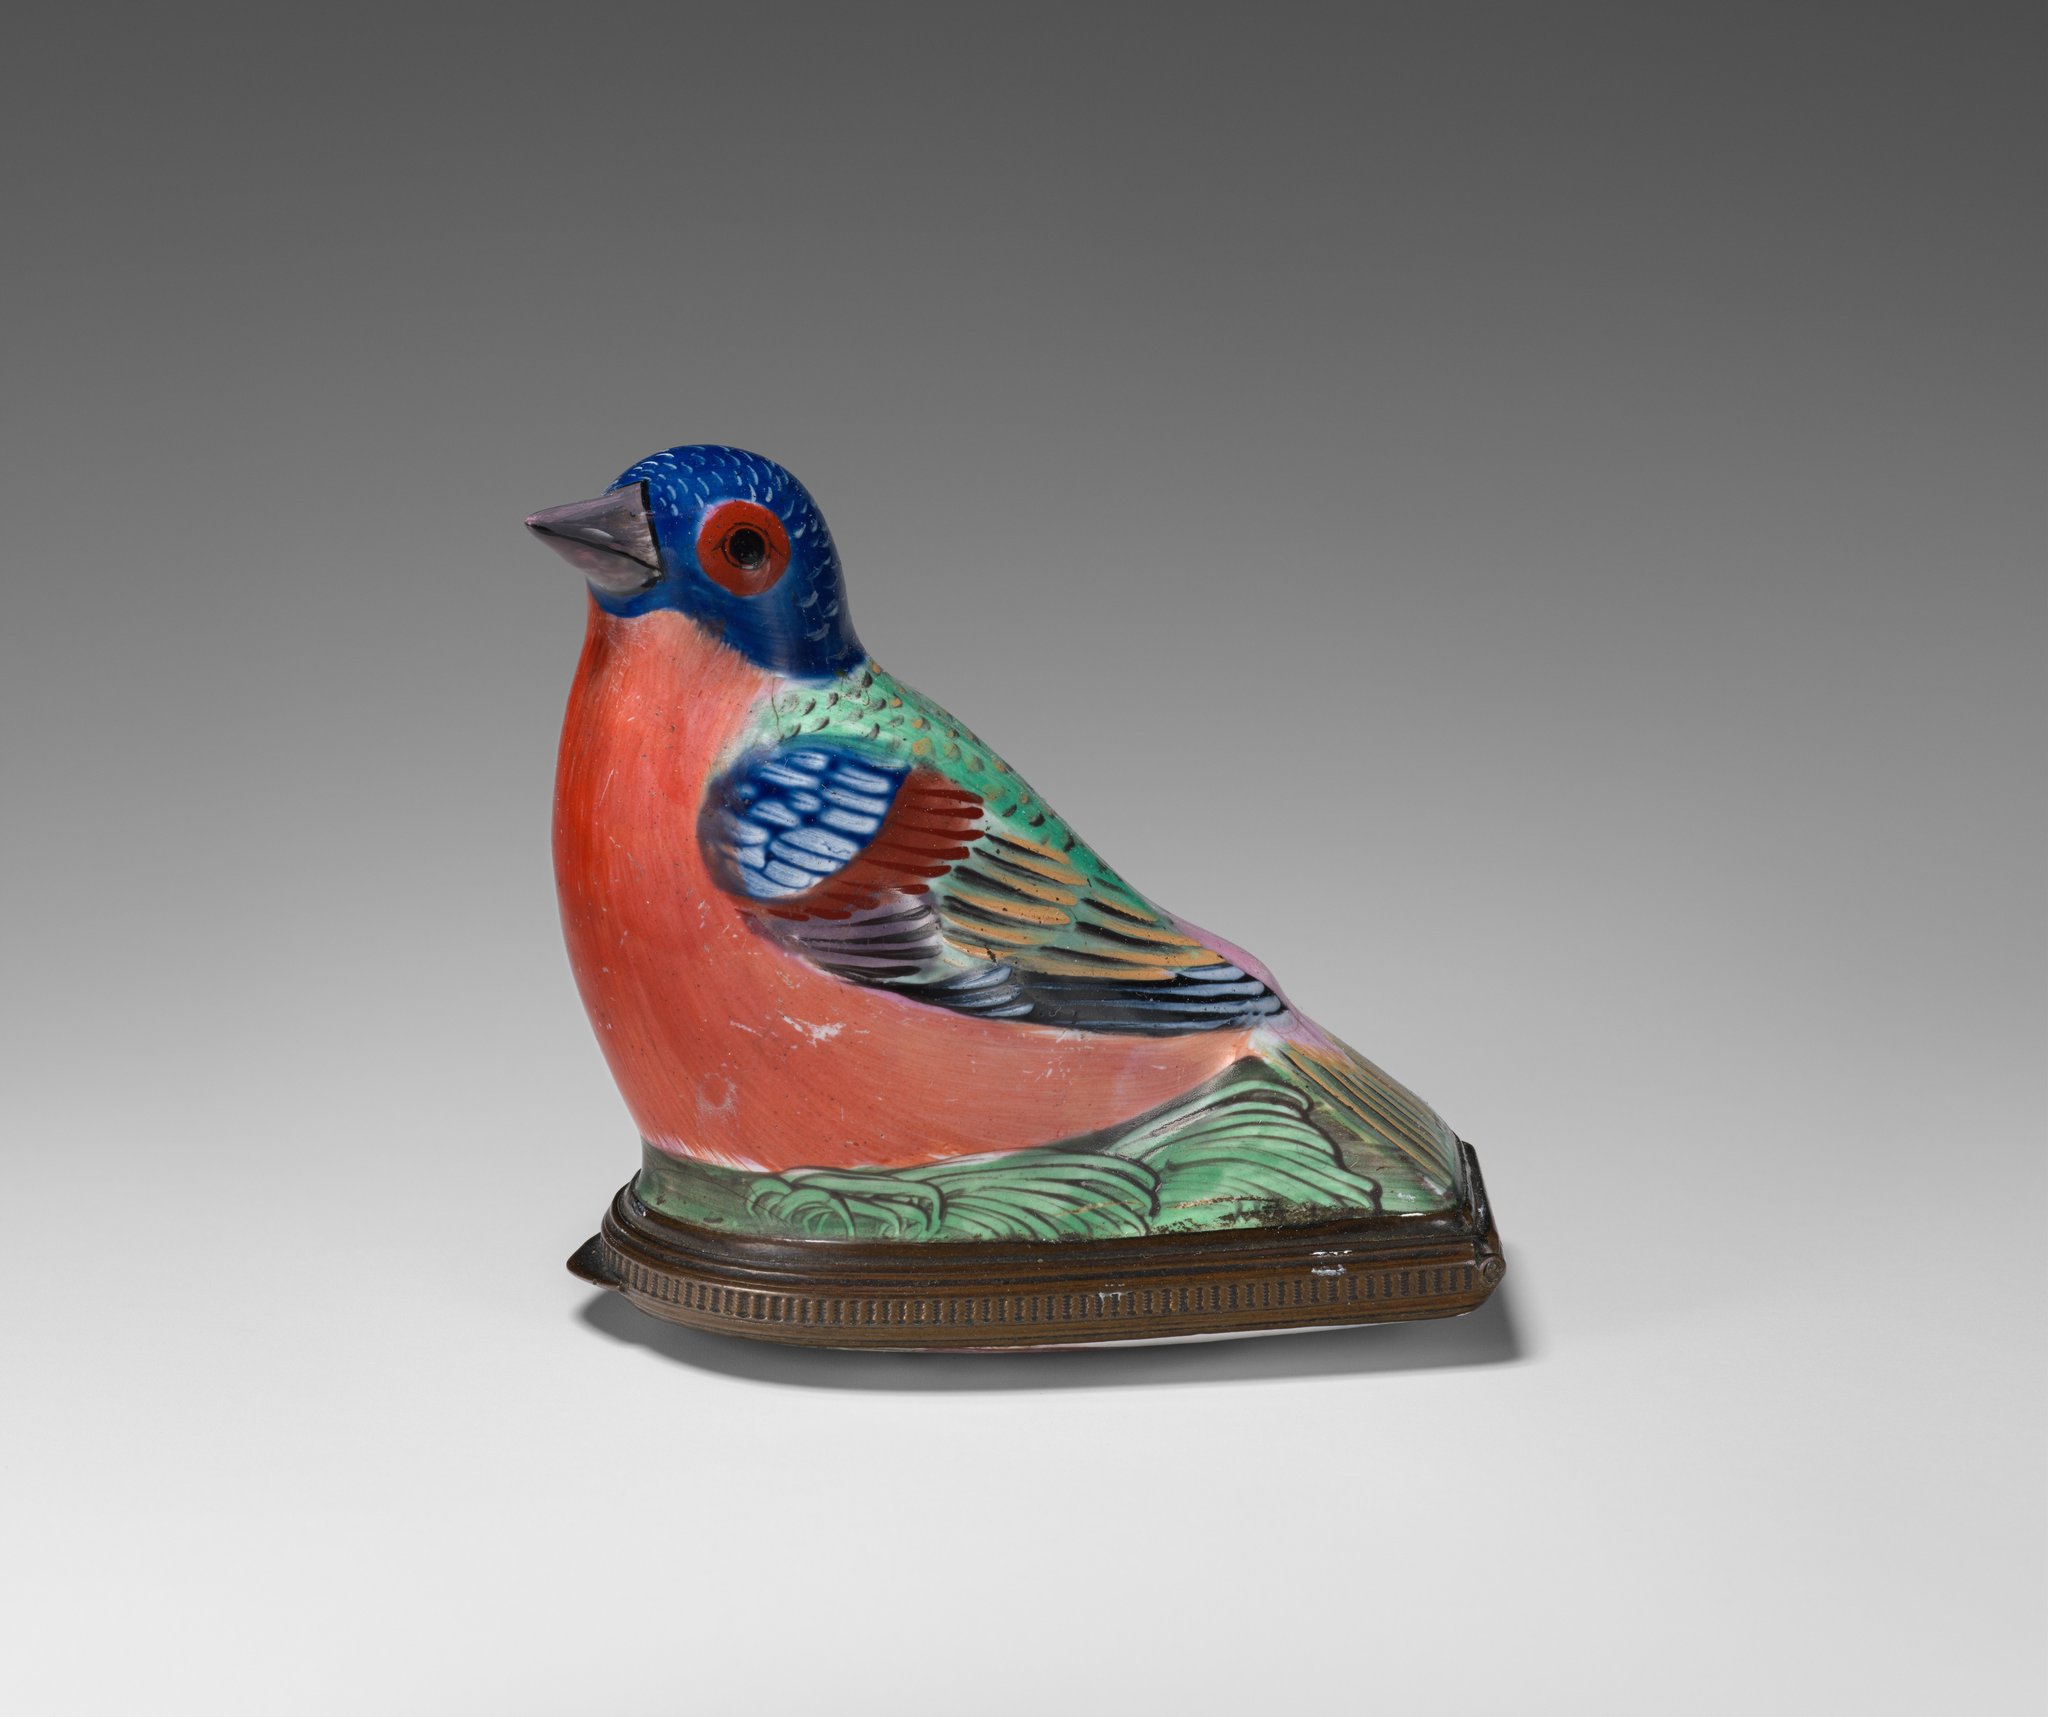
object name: bonbonnière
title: Bonbonnière in the form of a bird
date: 1770-1780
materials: copper, enamel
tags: birds